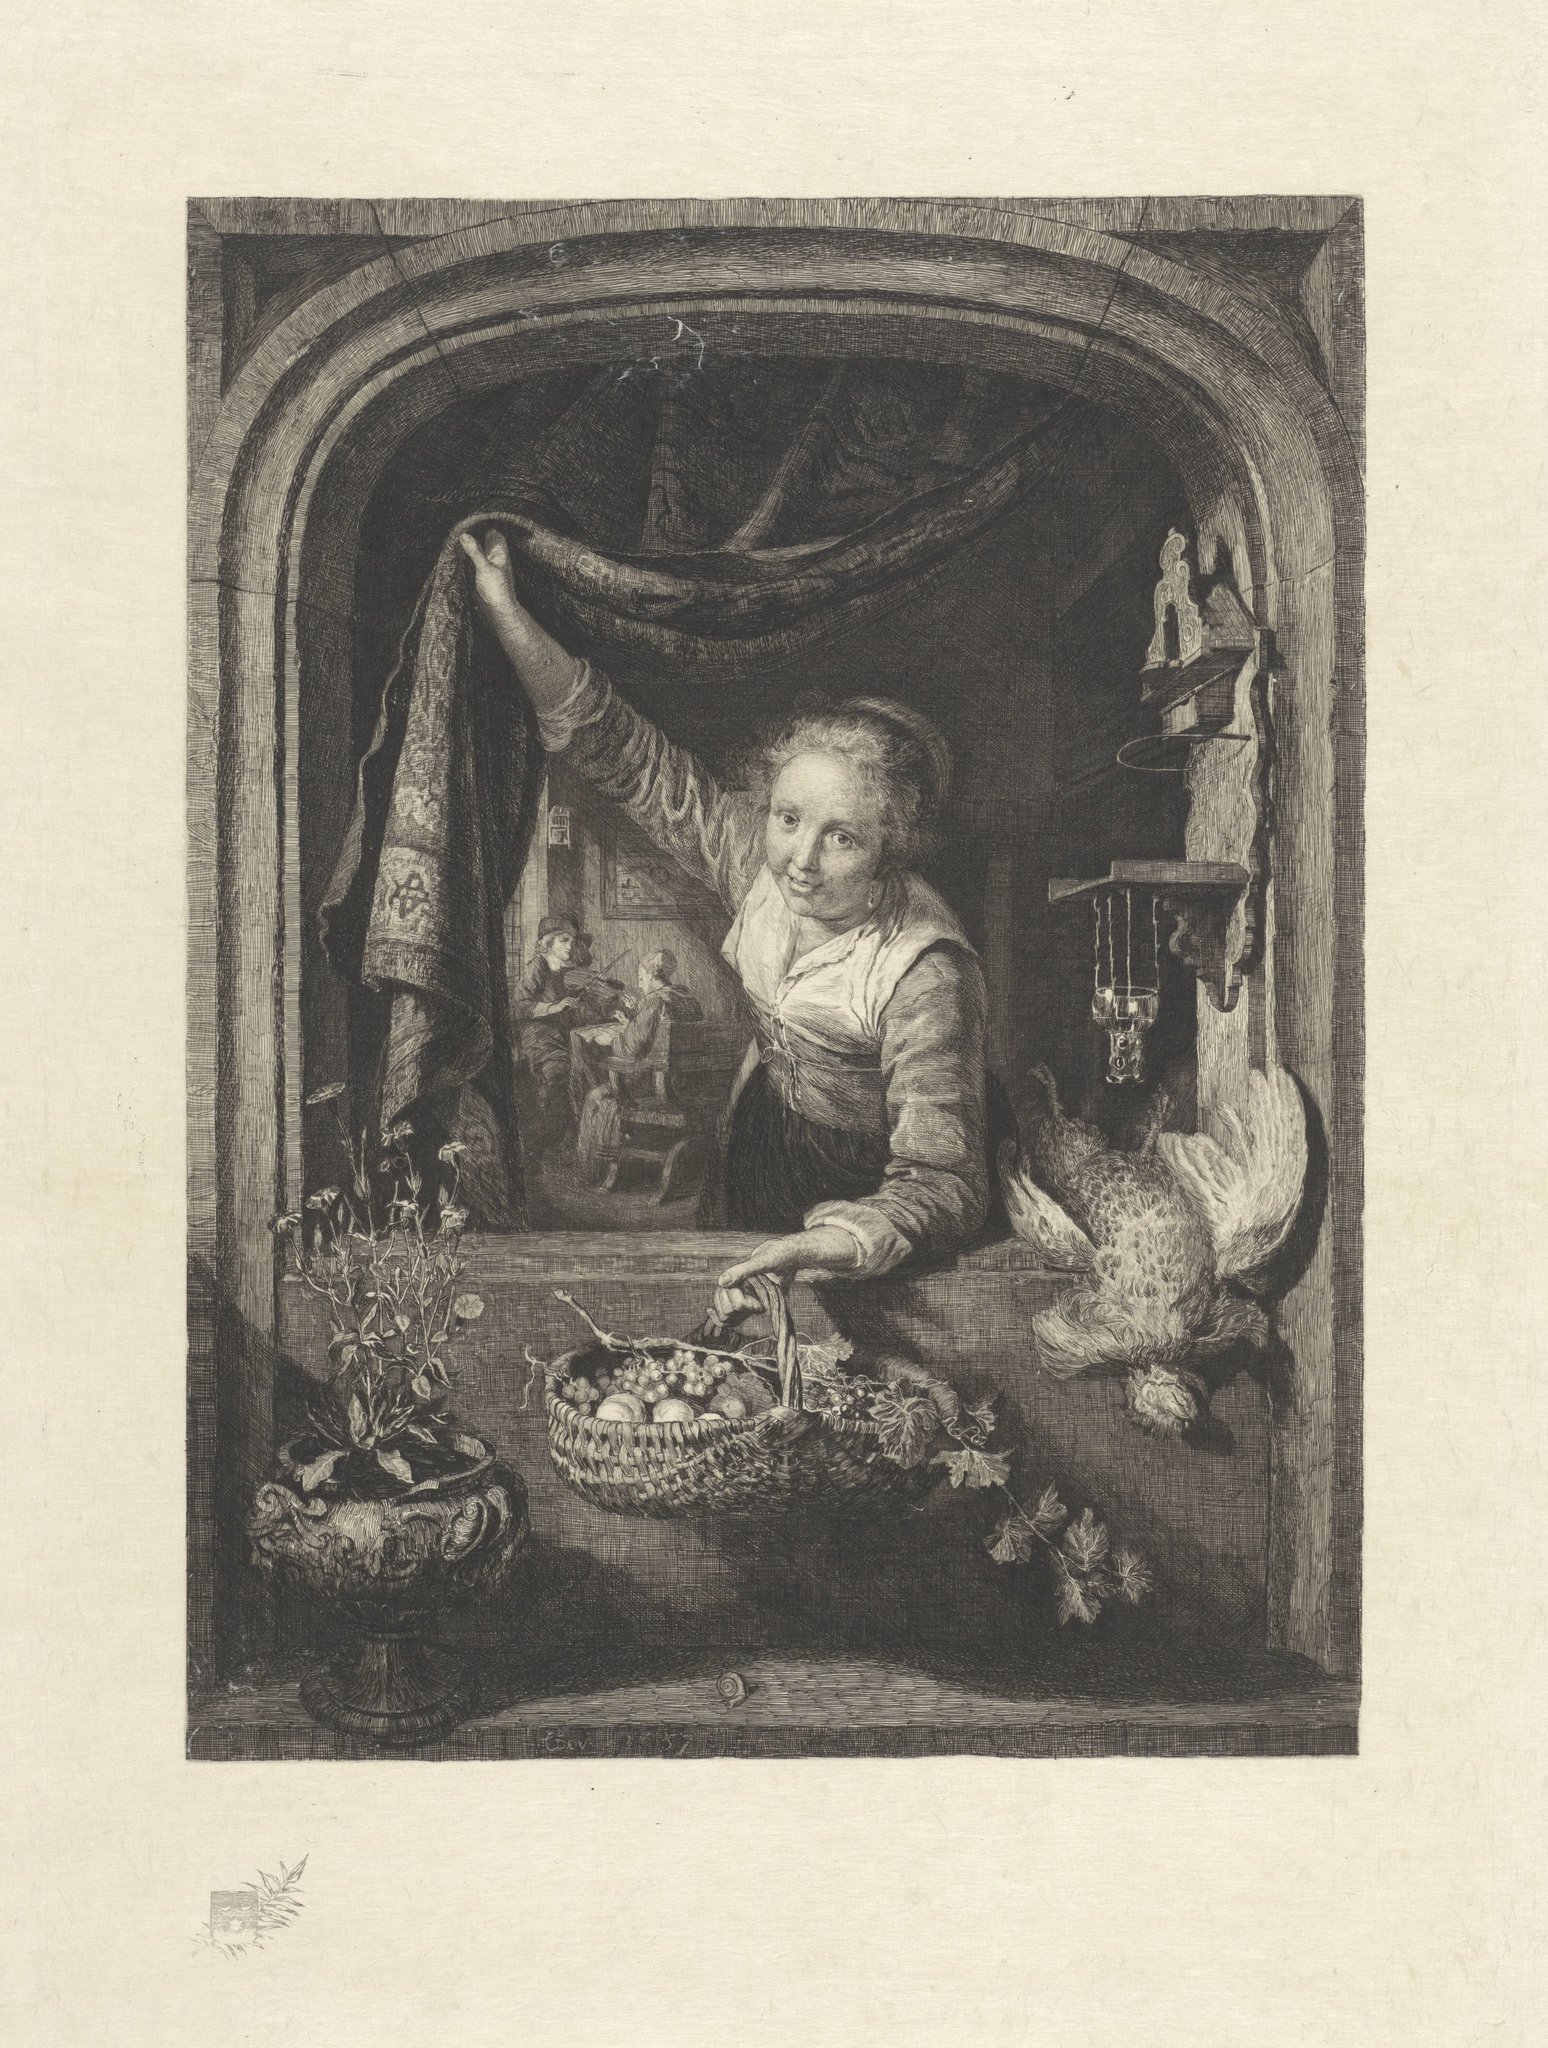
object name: print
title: Vrouw met fruitmand in venster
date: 1866-1928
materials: paper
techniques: etching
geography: netherlands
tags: human figure at (open) window, seen from outside - aa - feigned window, interior of the house, fruits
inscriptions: collector's mark: Lugt 2760, collector's mark: Lugt 2228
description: Een vrouw leunt uit een venster met een mand vol fruit in haar hand. In de vensterbank ligt een dode vogel. In het interieur speelt een man op een viool en zit een vrouw. Linksonder in de marge een wapenschild op een takje met bladeren.